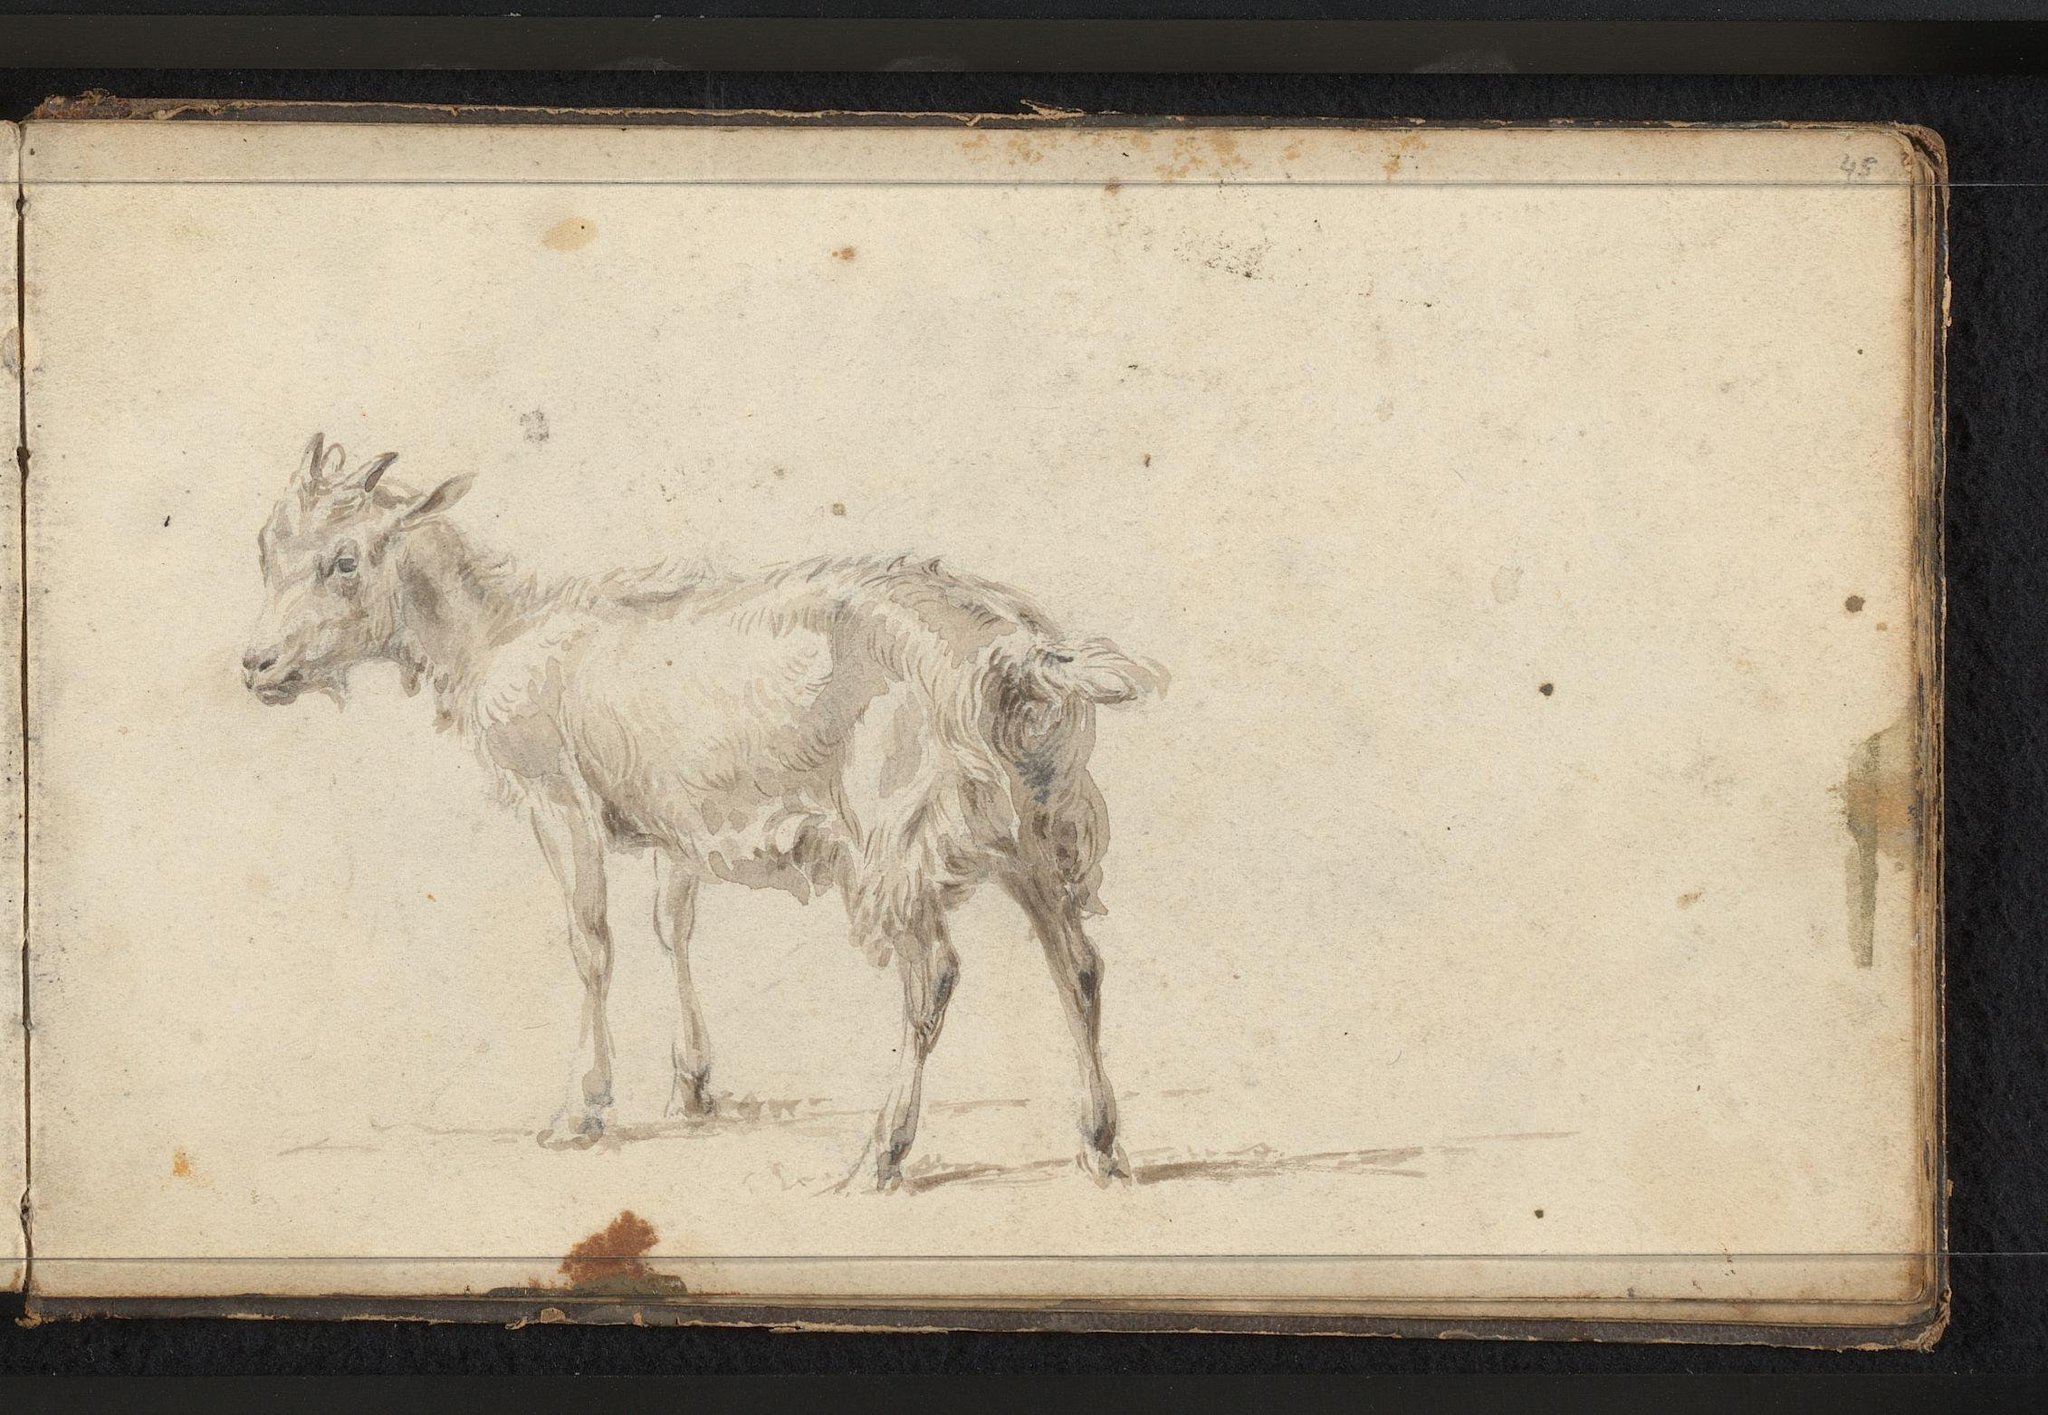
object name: sketchbook leaf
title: Bok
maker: jan bedijs tom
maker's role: draughtsman, painter, print maker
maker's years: 1813-1894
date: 1828-1894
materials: paper, pencil, watercolor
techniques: brush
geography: the hague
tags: he-goat, billy-goat, artist (in general) making preliminary designs, sketching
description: Pagina 44 recto uit een schetsboek met 54 bladen.